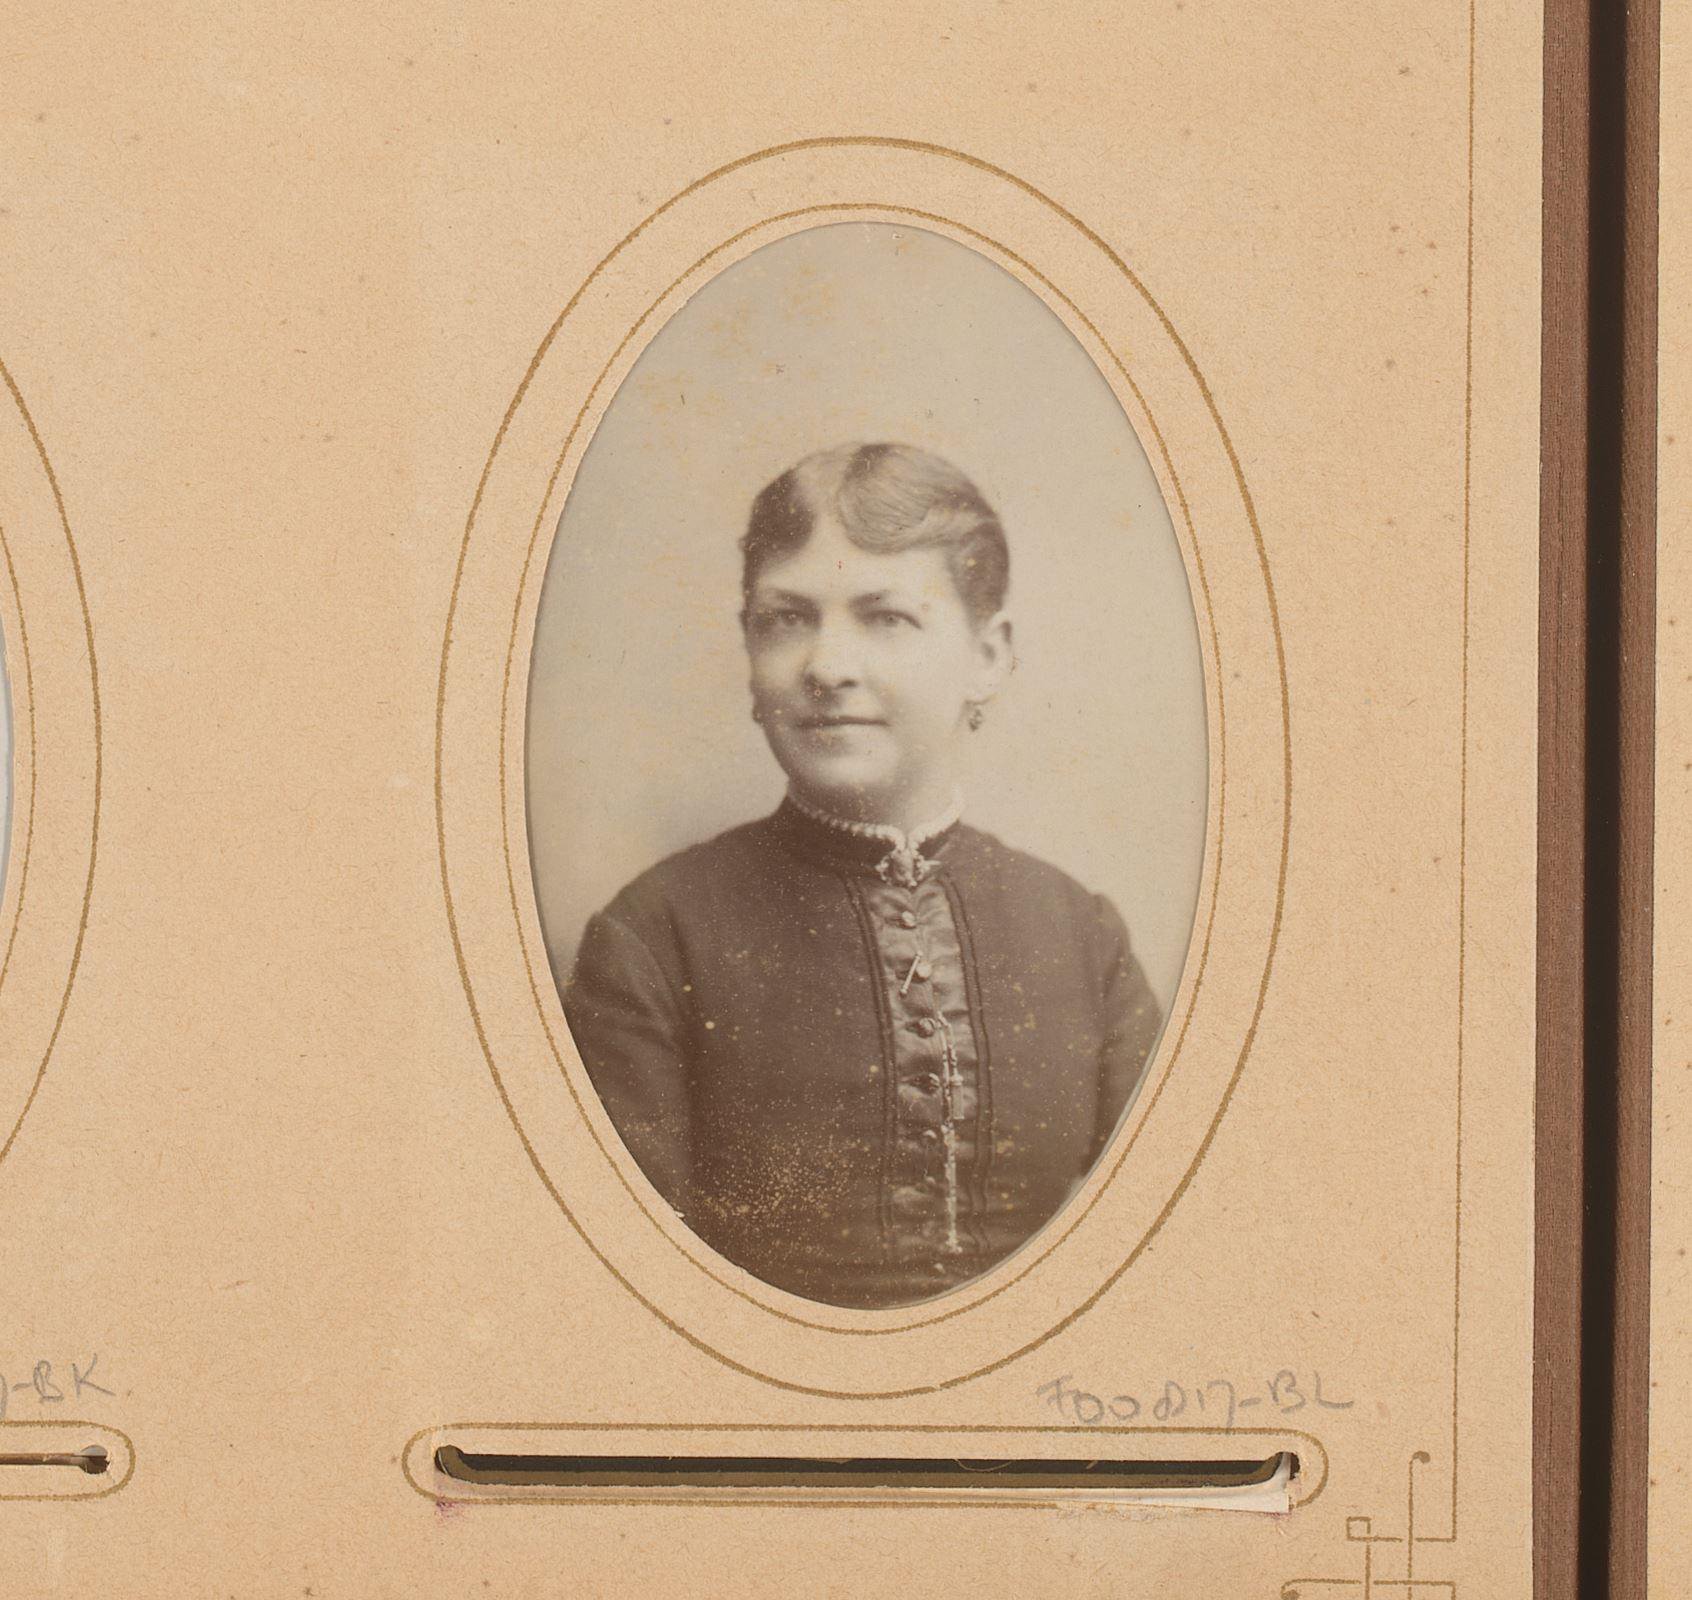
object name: photograph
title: Portret van een vrouw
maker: j.w. wentzel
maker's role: fotograaf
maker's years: 1855-1930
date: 1883-1890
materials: cardboard, photographic support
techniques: albumen print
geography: amersfoort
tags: historical persons - bb - woman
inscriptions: inscription: ‘Photographie instantanée van J.W. Wentzel/ Langegracht F.200/ Amersfoort’